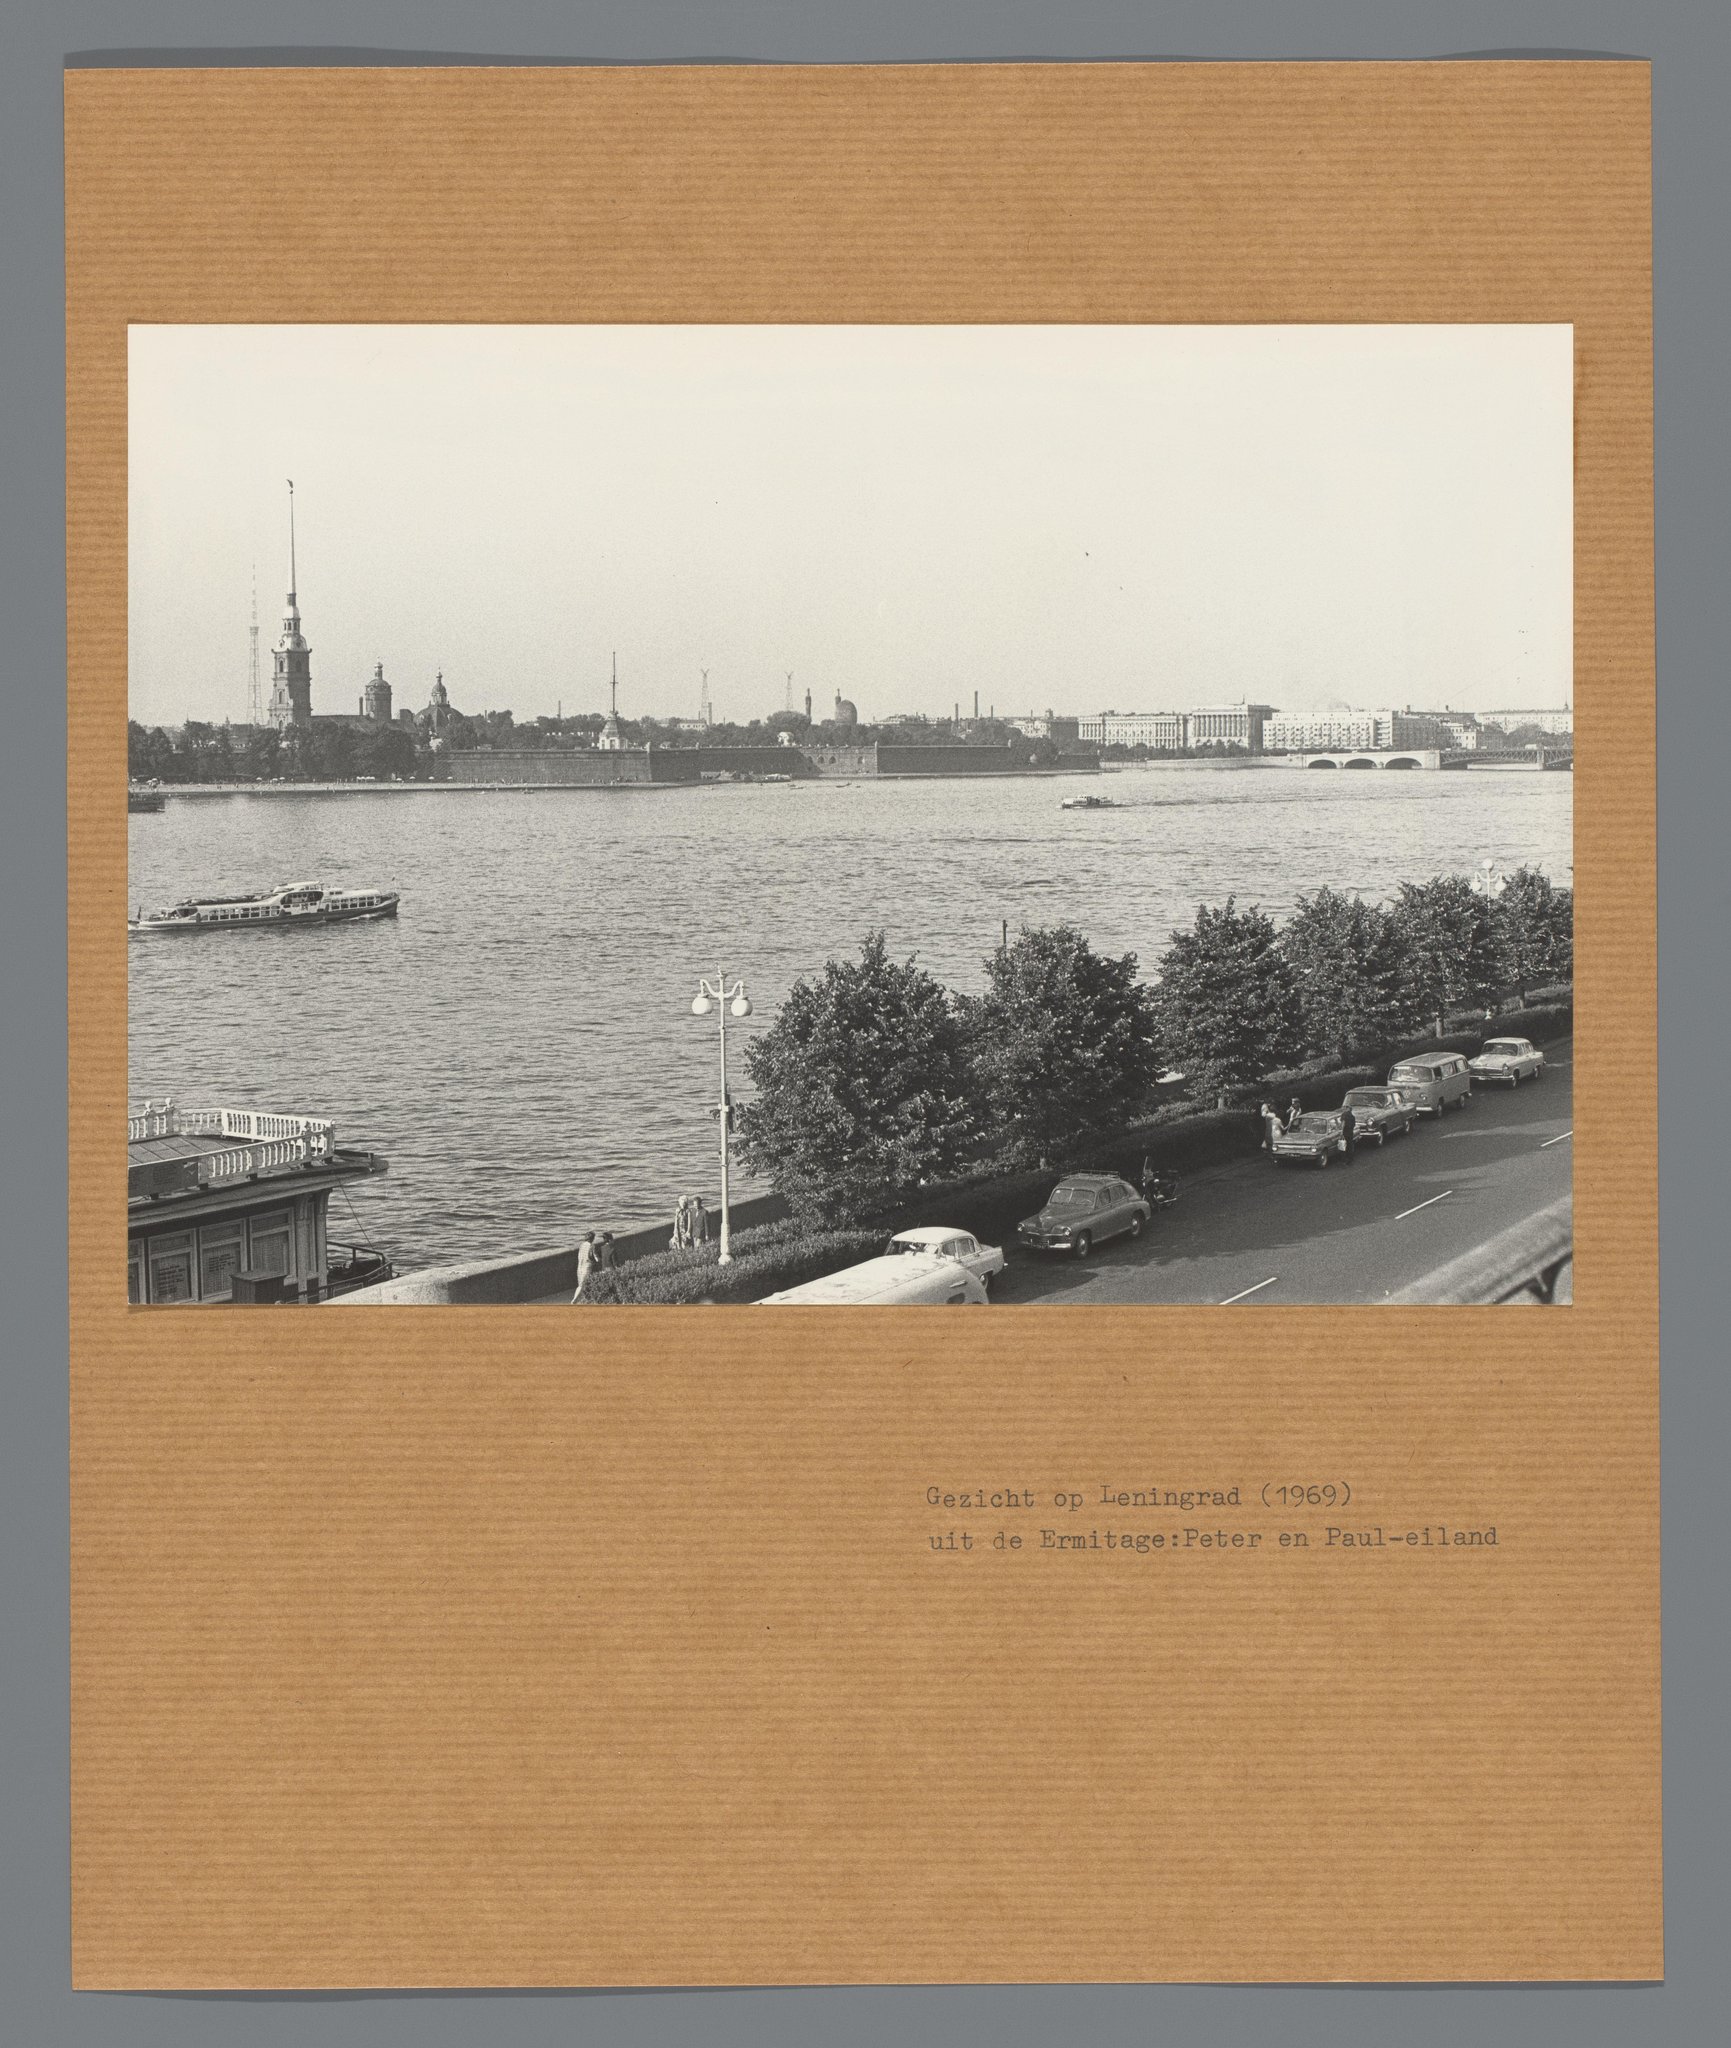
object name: photograph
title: Gezicht op Leningrad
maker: Anonymous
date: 1969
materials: photographic support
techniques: gelatin silver print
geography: russia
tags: leningrad